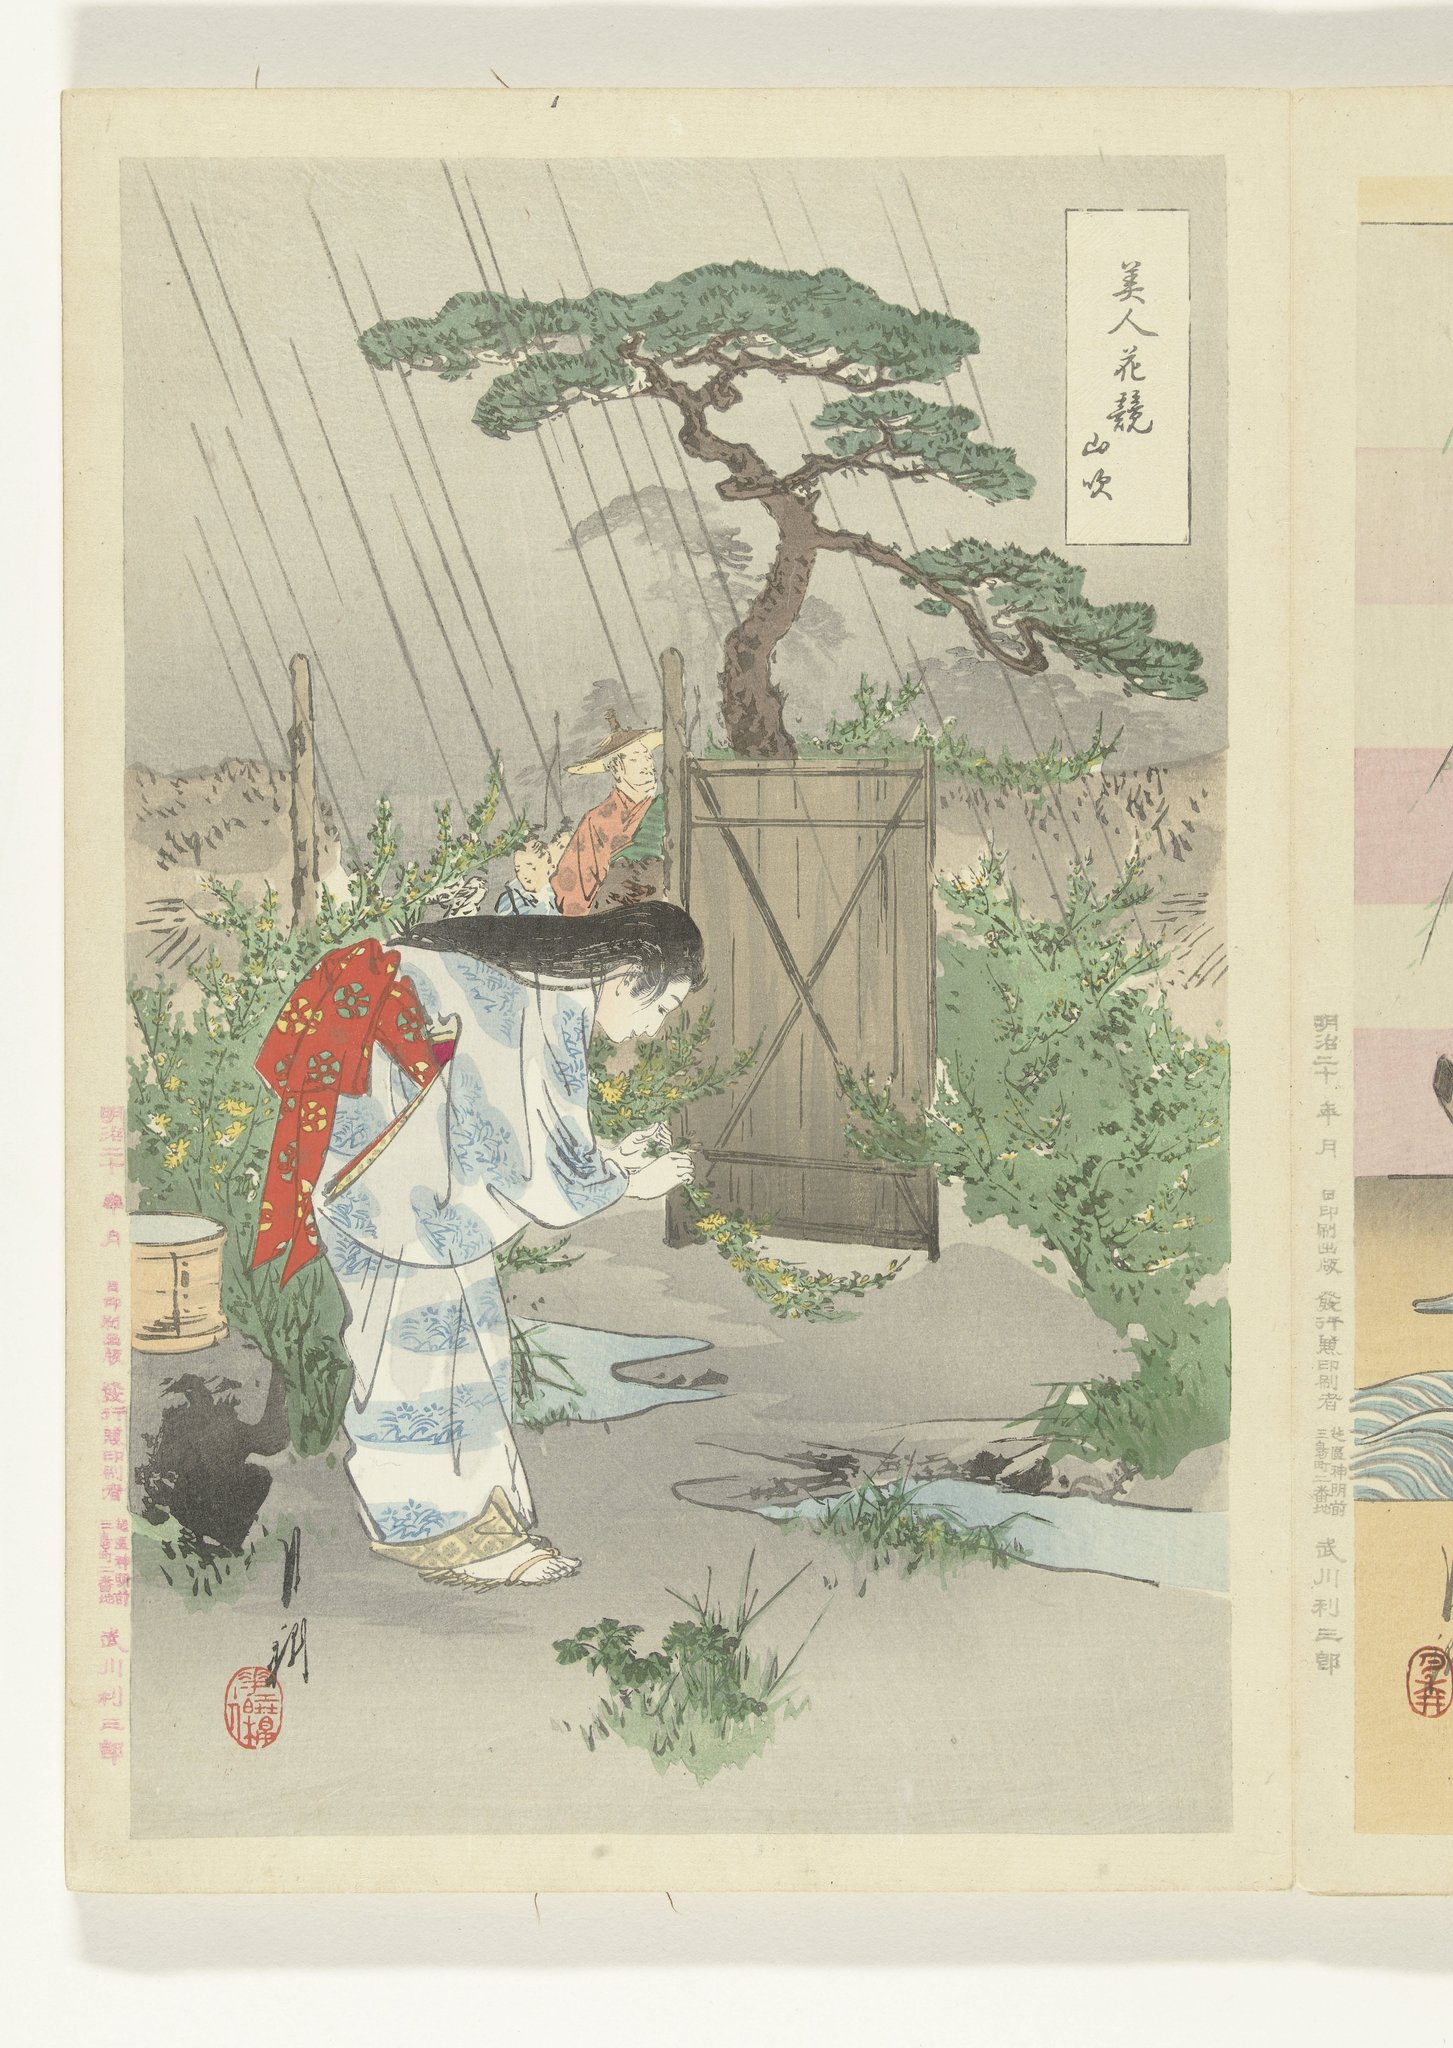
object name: print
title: Yamabuki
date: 1887-1896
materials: paper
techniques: blind stamped, woodcut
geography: japan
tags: adult woman, garden, rain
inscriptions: collector's mark: Lugt 2228, collector's mark: Lugt 2760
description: Vrouw in de regen, in een tuin kijkend naar struik met gele bloemen; achter het hek een man met kinderen.